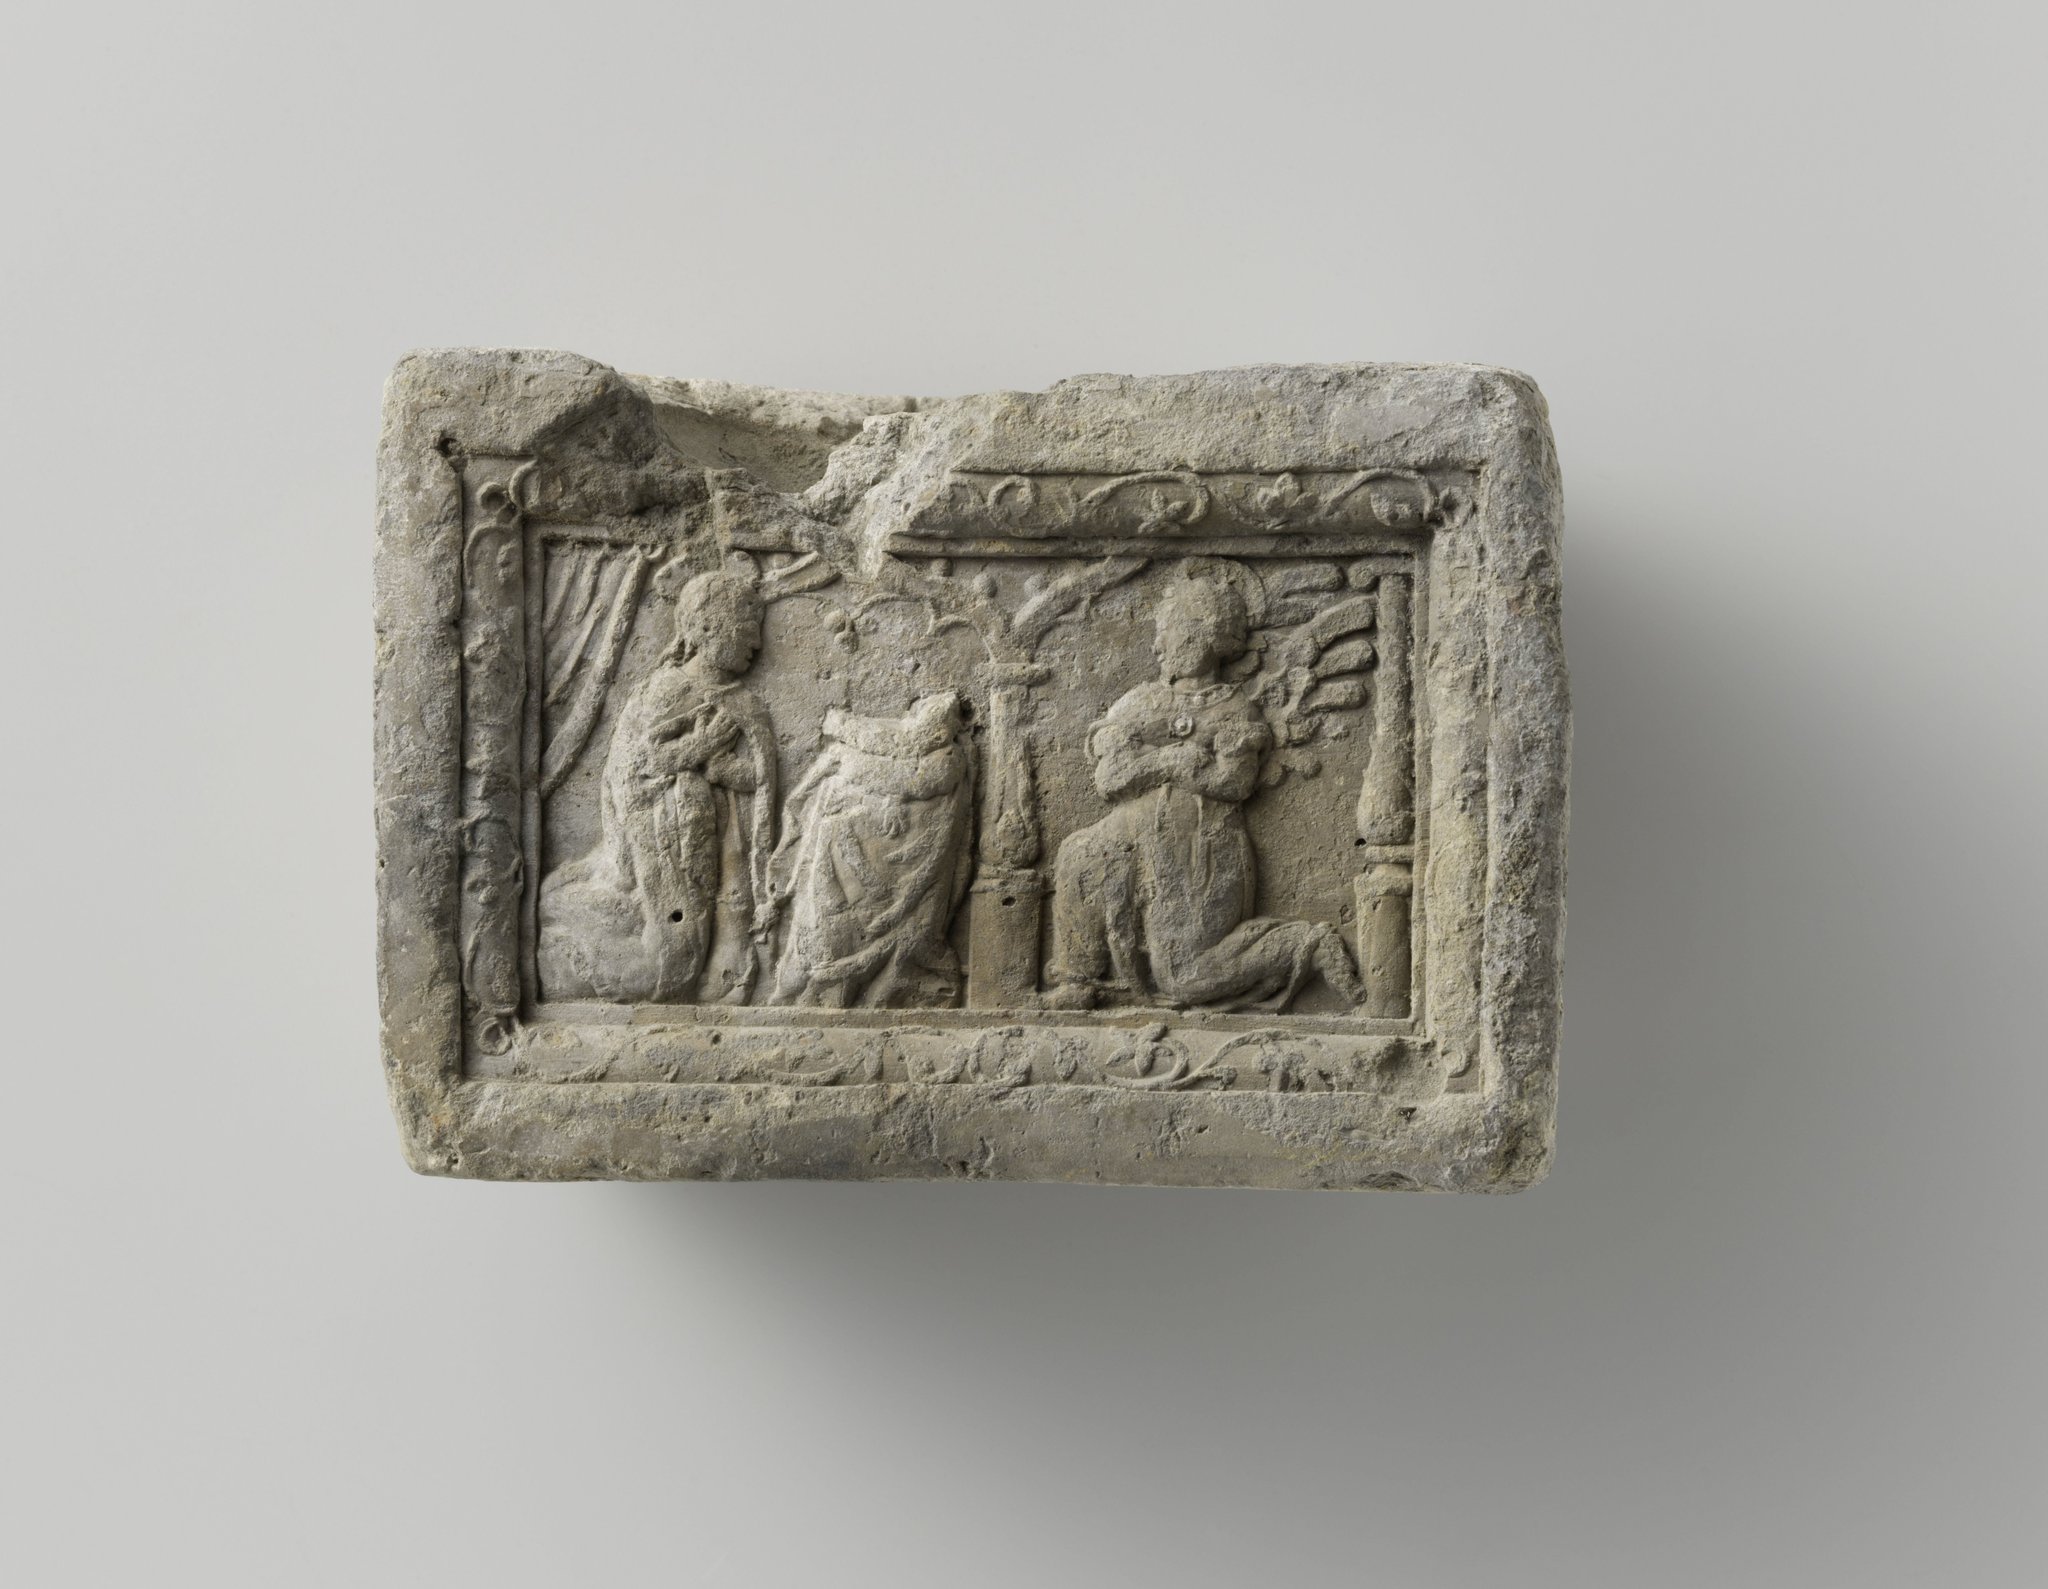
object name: hearthstone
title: Haardsteen, waarop Maria voor een bidstoel, de engel eveneens geknield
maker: Anonymous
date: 1540-1560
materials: earthenware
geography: southern netherlands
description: Haardsteen, waarop Maria voor een bidstoel, de engel eveneens geknield; de blijde boodschap. In twee nissen met gothisch traceerwerk. Van fijne gebakken aarde.